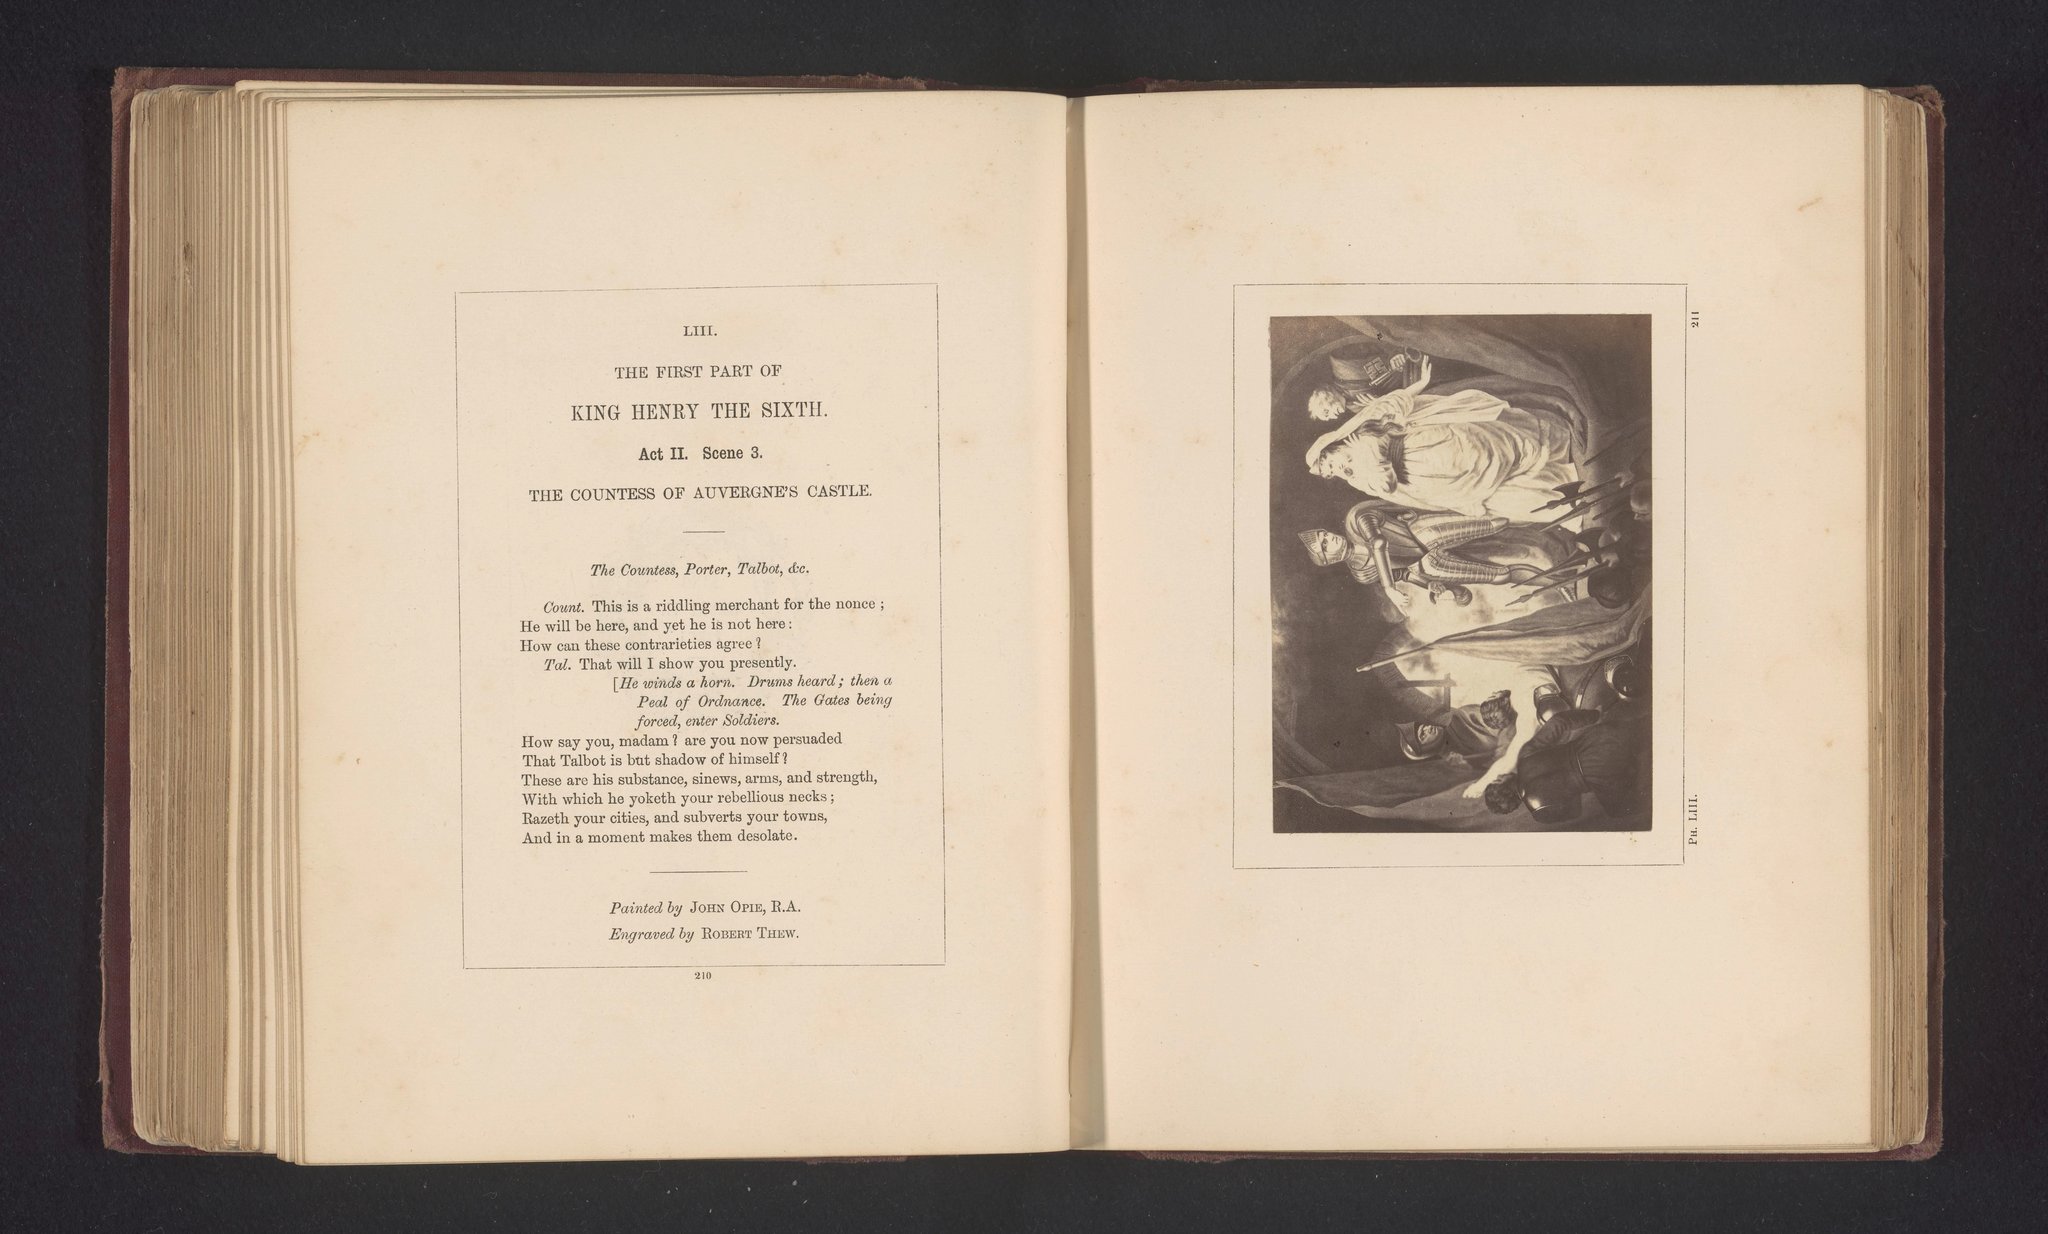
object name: reproduction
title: Fotoreproductie van een prent naar een schilderij door John Opie, voorstellend een scene uit Hendrik VI, deel 1 door William Shakespeare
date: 1854-1867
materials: photographic support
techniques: albumen print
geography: london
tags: specific works of literature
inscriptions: number: ‘Ph. LIII. 211’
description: Te zien is akte II, scene 3 met mannen in harnassen naast de gravin van Auvergne.